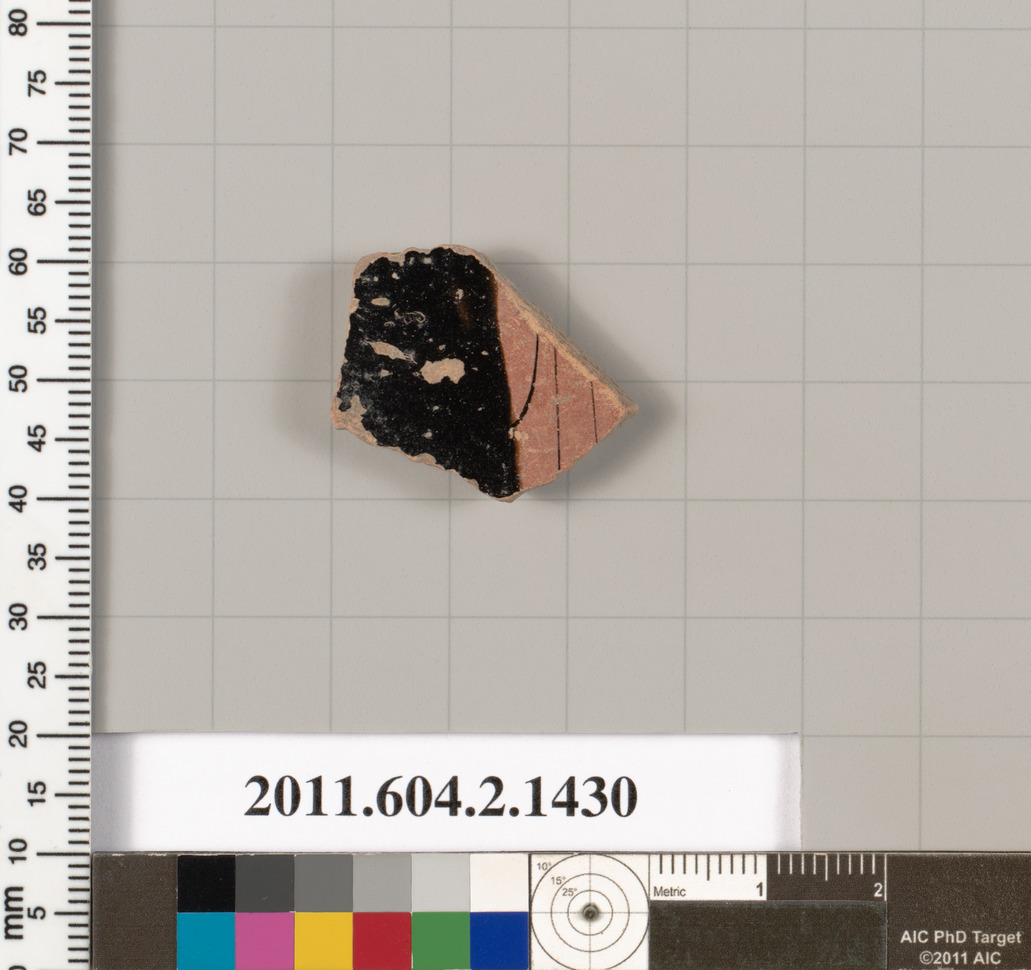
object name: skyphos fragment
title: Terracotta fragment of a skyphos (deep drinking cup)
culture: greek, attic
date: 475-451 BCE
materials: terracotta